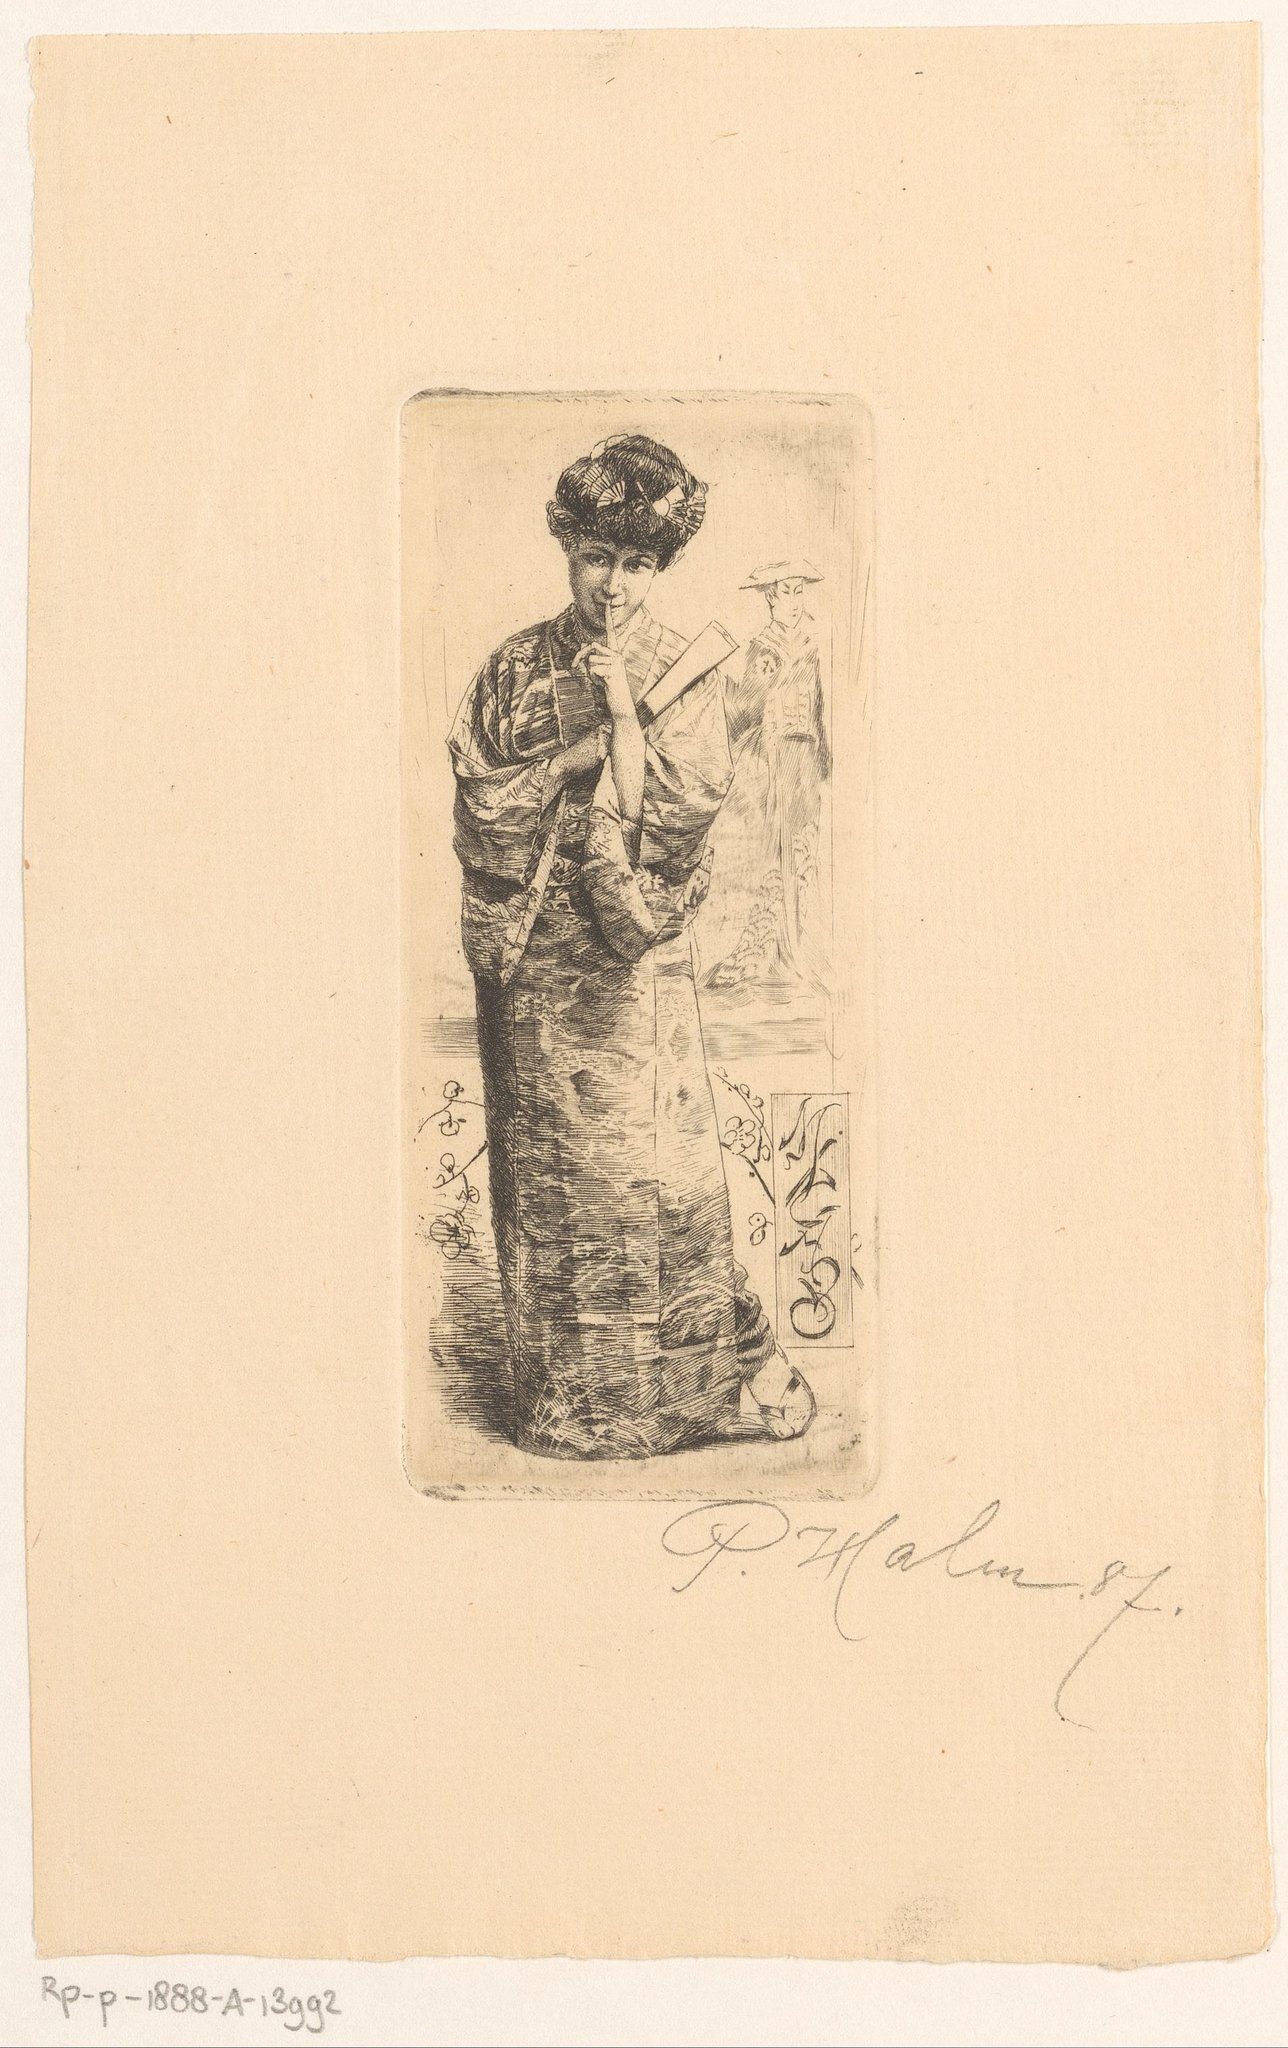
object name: print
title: Vrouw in traditionele Japanse kledij met vinger voor de mond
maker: peter von halm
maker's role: print maker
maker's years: 1854-1923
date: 1887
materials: paper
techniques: etching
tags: japanese, folk costume, regional costume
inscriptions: collector's mark: Lugt 2228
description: Rechtsonder in een kader het woord Micado.